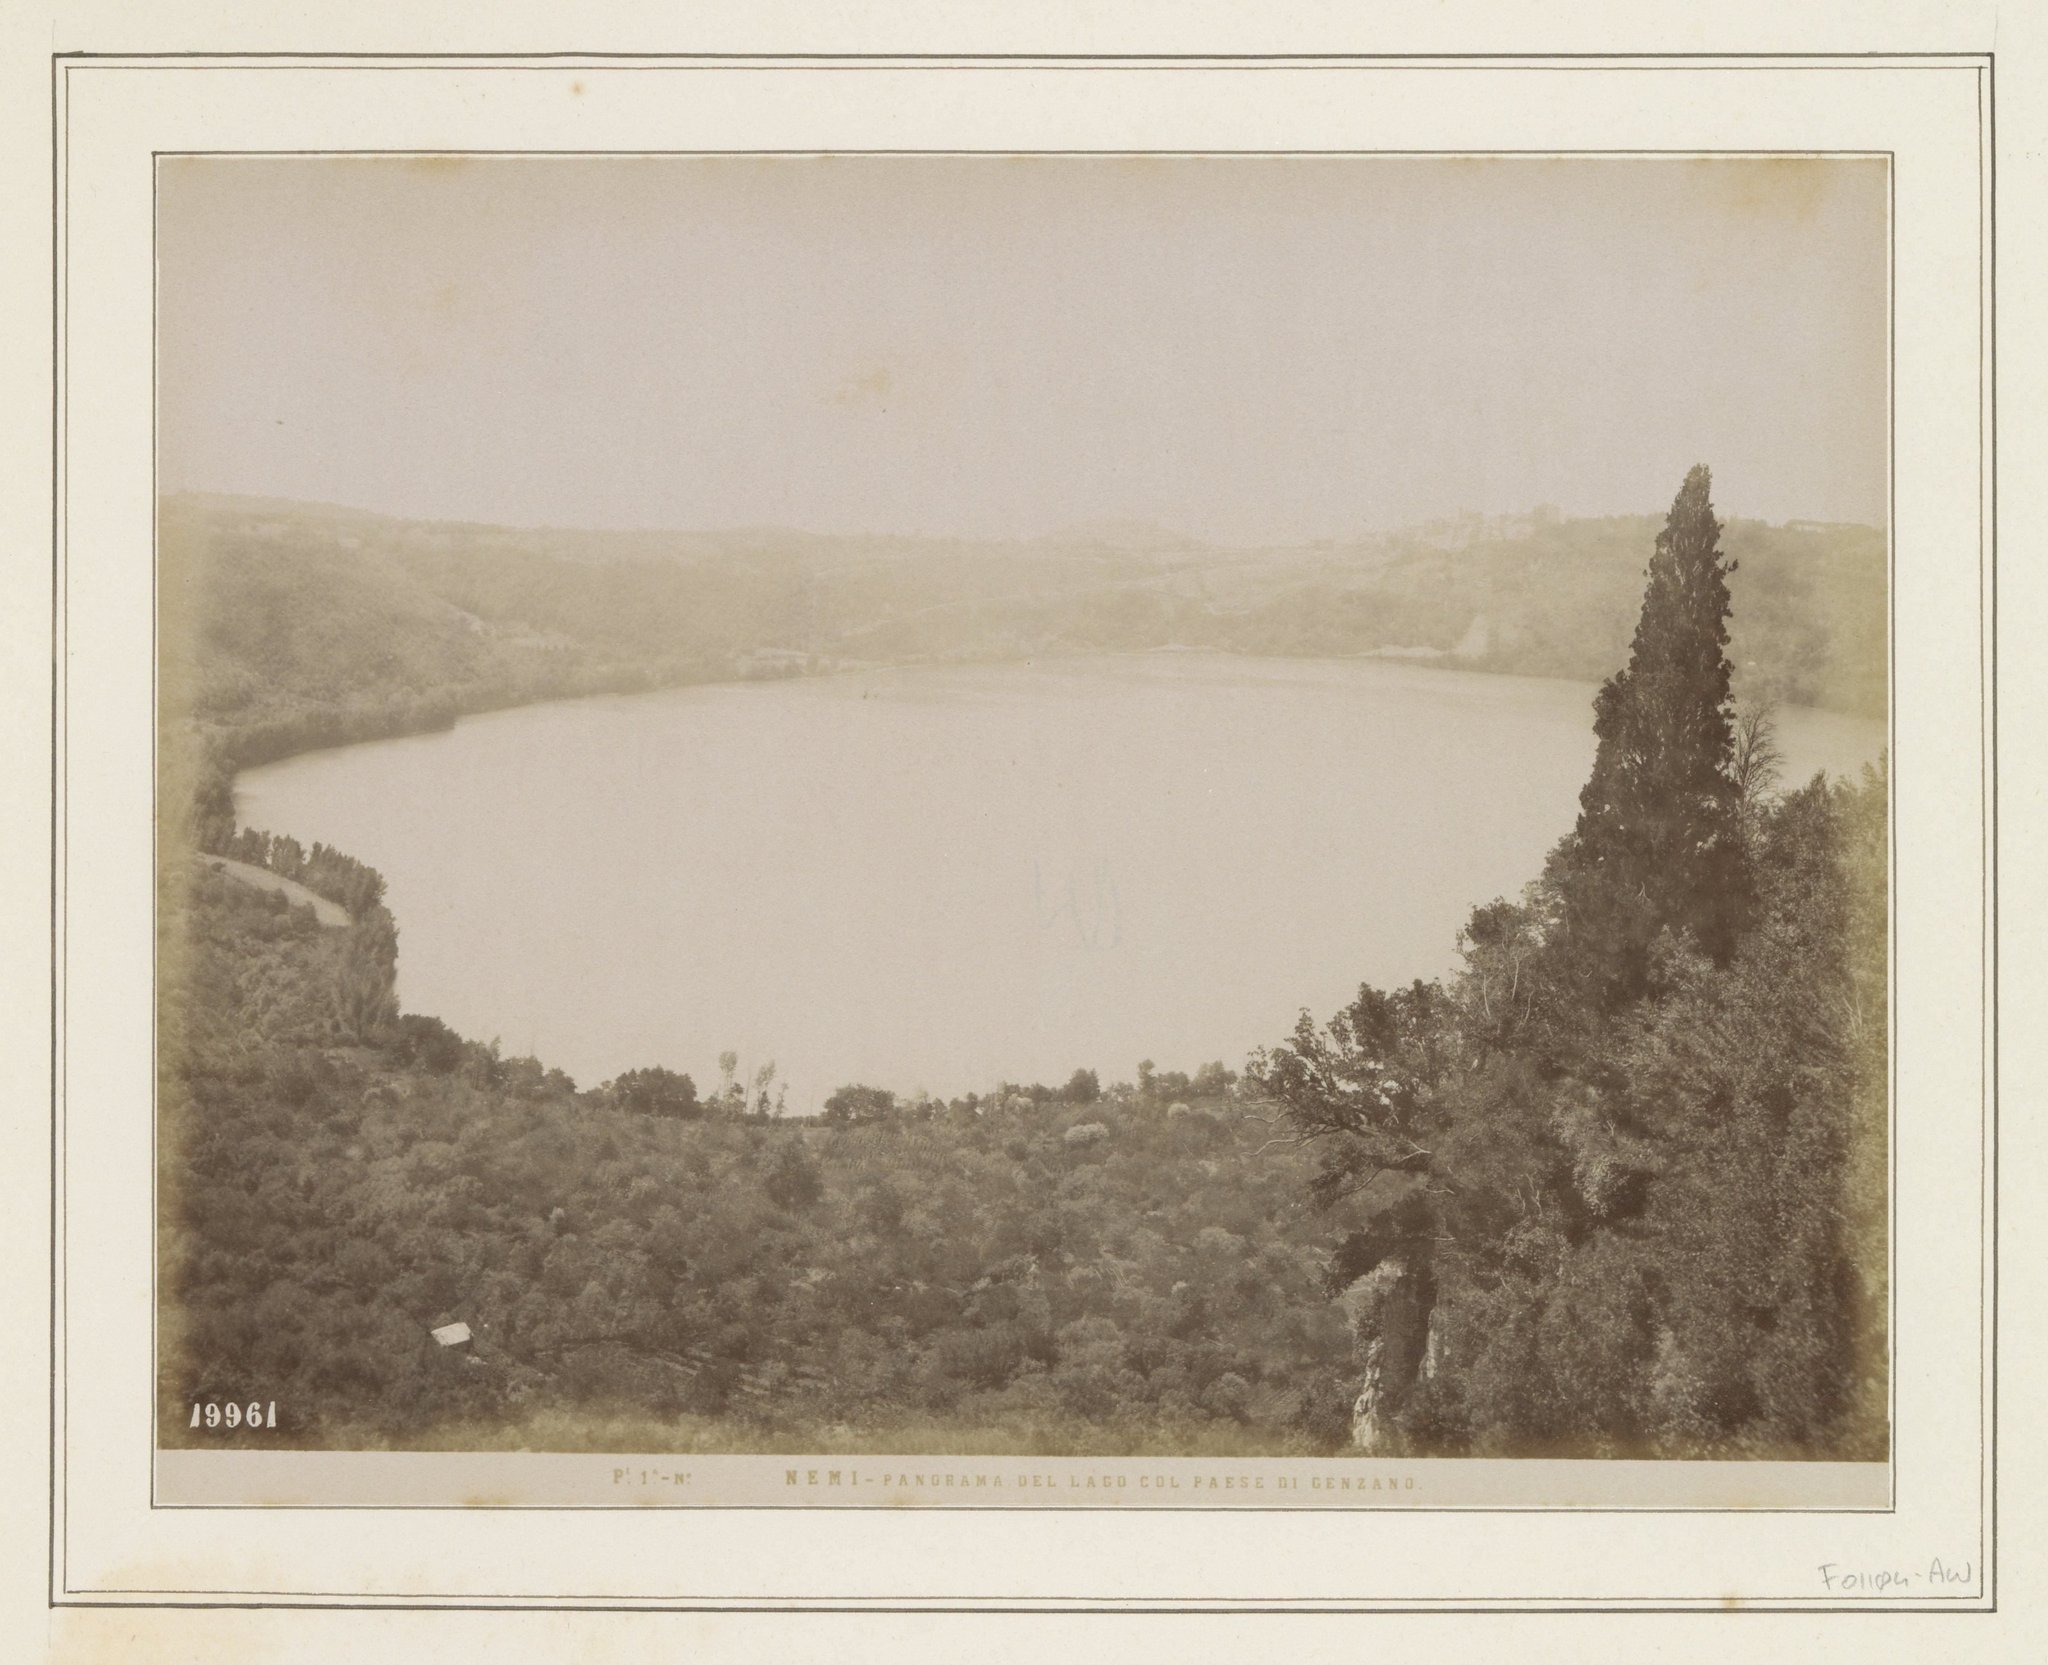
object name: photograph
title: Gezicht op een meer en het landschap bij Genzano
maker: Anonymous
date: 1865-1890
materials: paper, photographic support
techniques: albumen print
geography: genzano di roma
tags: lake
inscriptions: number: ‘Pe.-1A-No.’, number: ‘19961’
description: Onderdeel van Reisalbum met foto's van bezienswaardigheden in Italië (deel I).